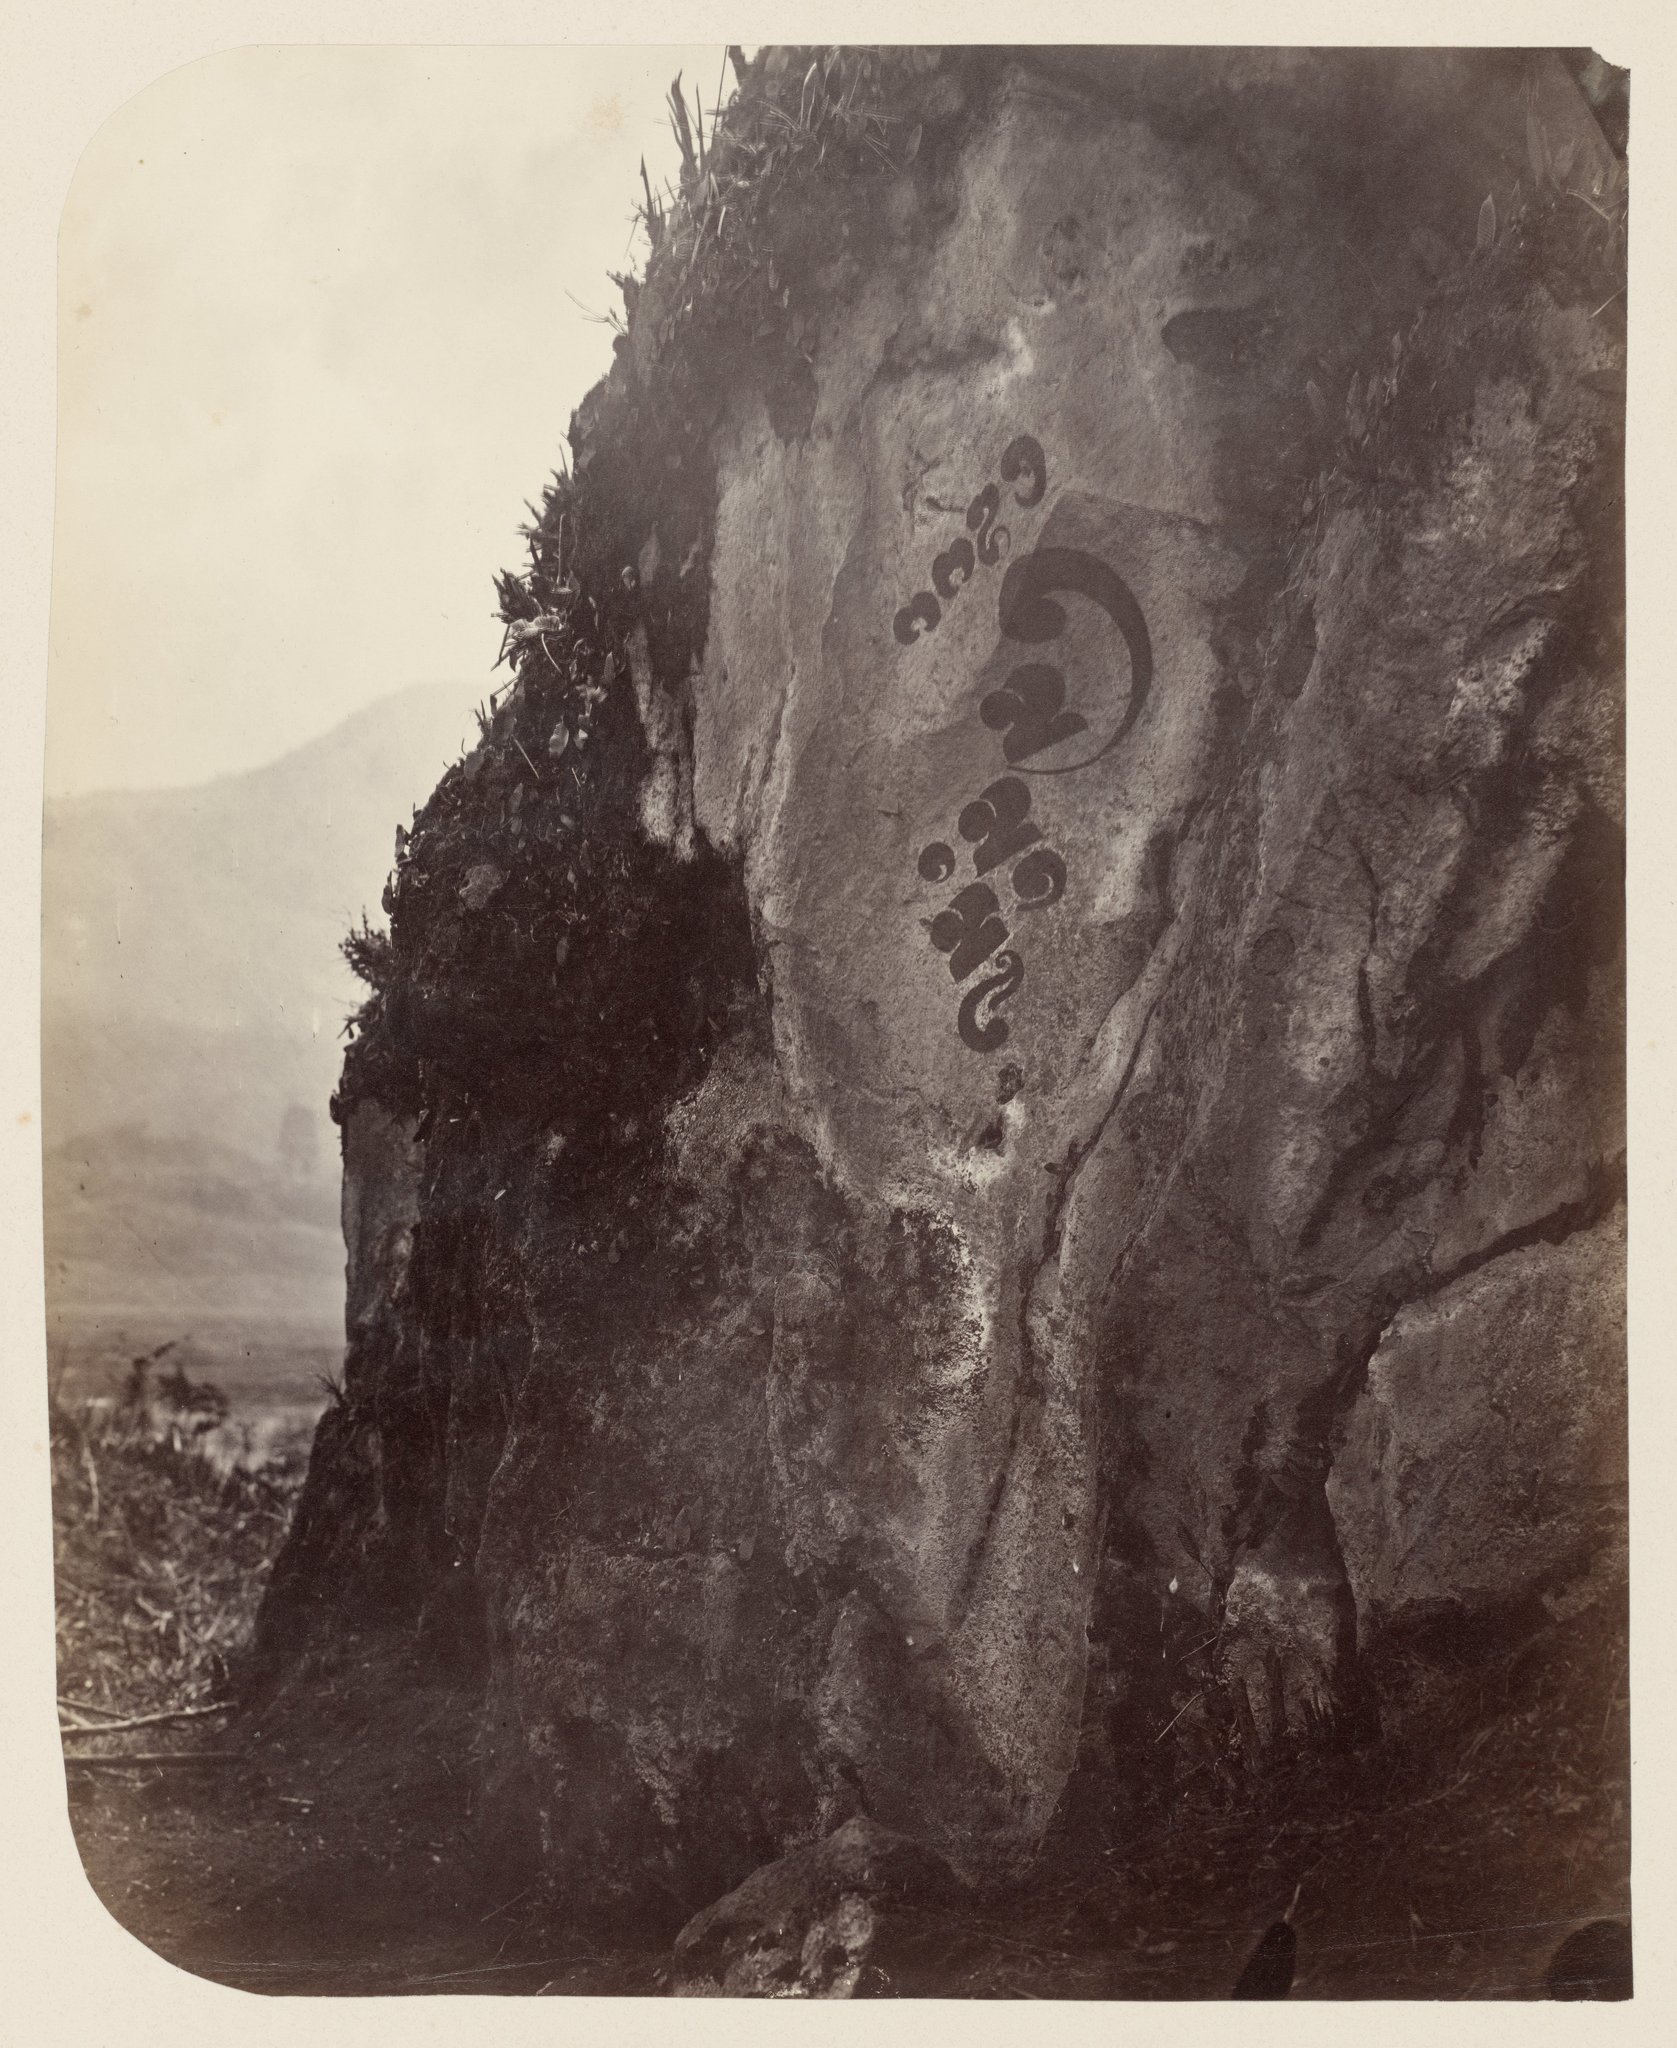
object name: photograph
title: Crag with Inscription on the Dieng Plateau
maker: isidore kinsbergen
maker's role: fotograaf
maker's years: 1821-1905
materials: cardboard, paper, photographic support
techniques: albumen print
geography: java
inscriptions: title: ‘Rots met inscriptie te Diëng-plateau (Residentie Bagelen) Cat. no. 105’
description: Stone inscriptions are important for reconstructing the history of Java. Often they are also works of art in themselves. These large letters carved on a crag on the Dieng Plateau are highly decorative. At the top is a number corresponding to the year 1134 of the Shaka Era, or 1202 CE.